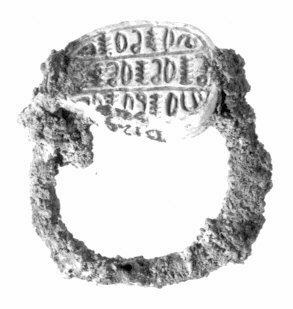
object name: stamp seal ring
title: Scarab seal ring with Hyksos-period an-ra inscription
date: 1700-1560 BCE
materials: bronze, stone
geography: levant